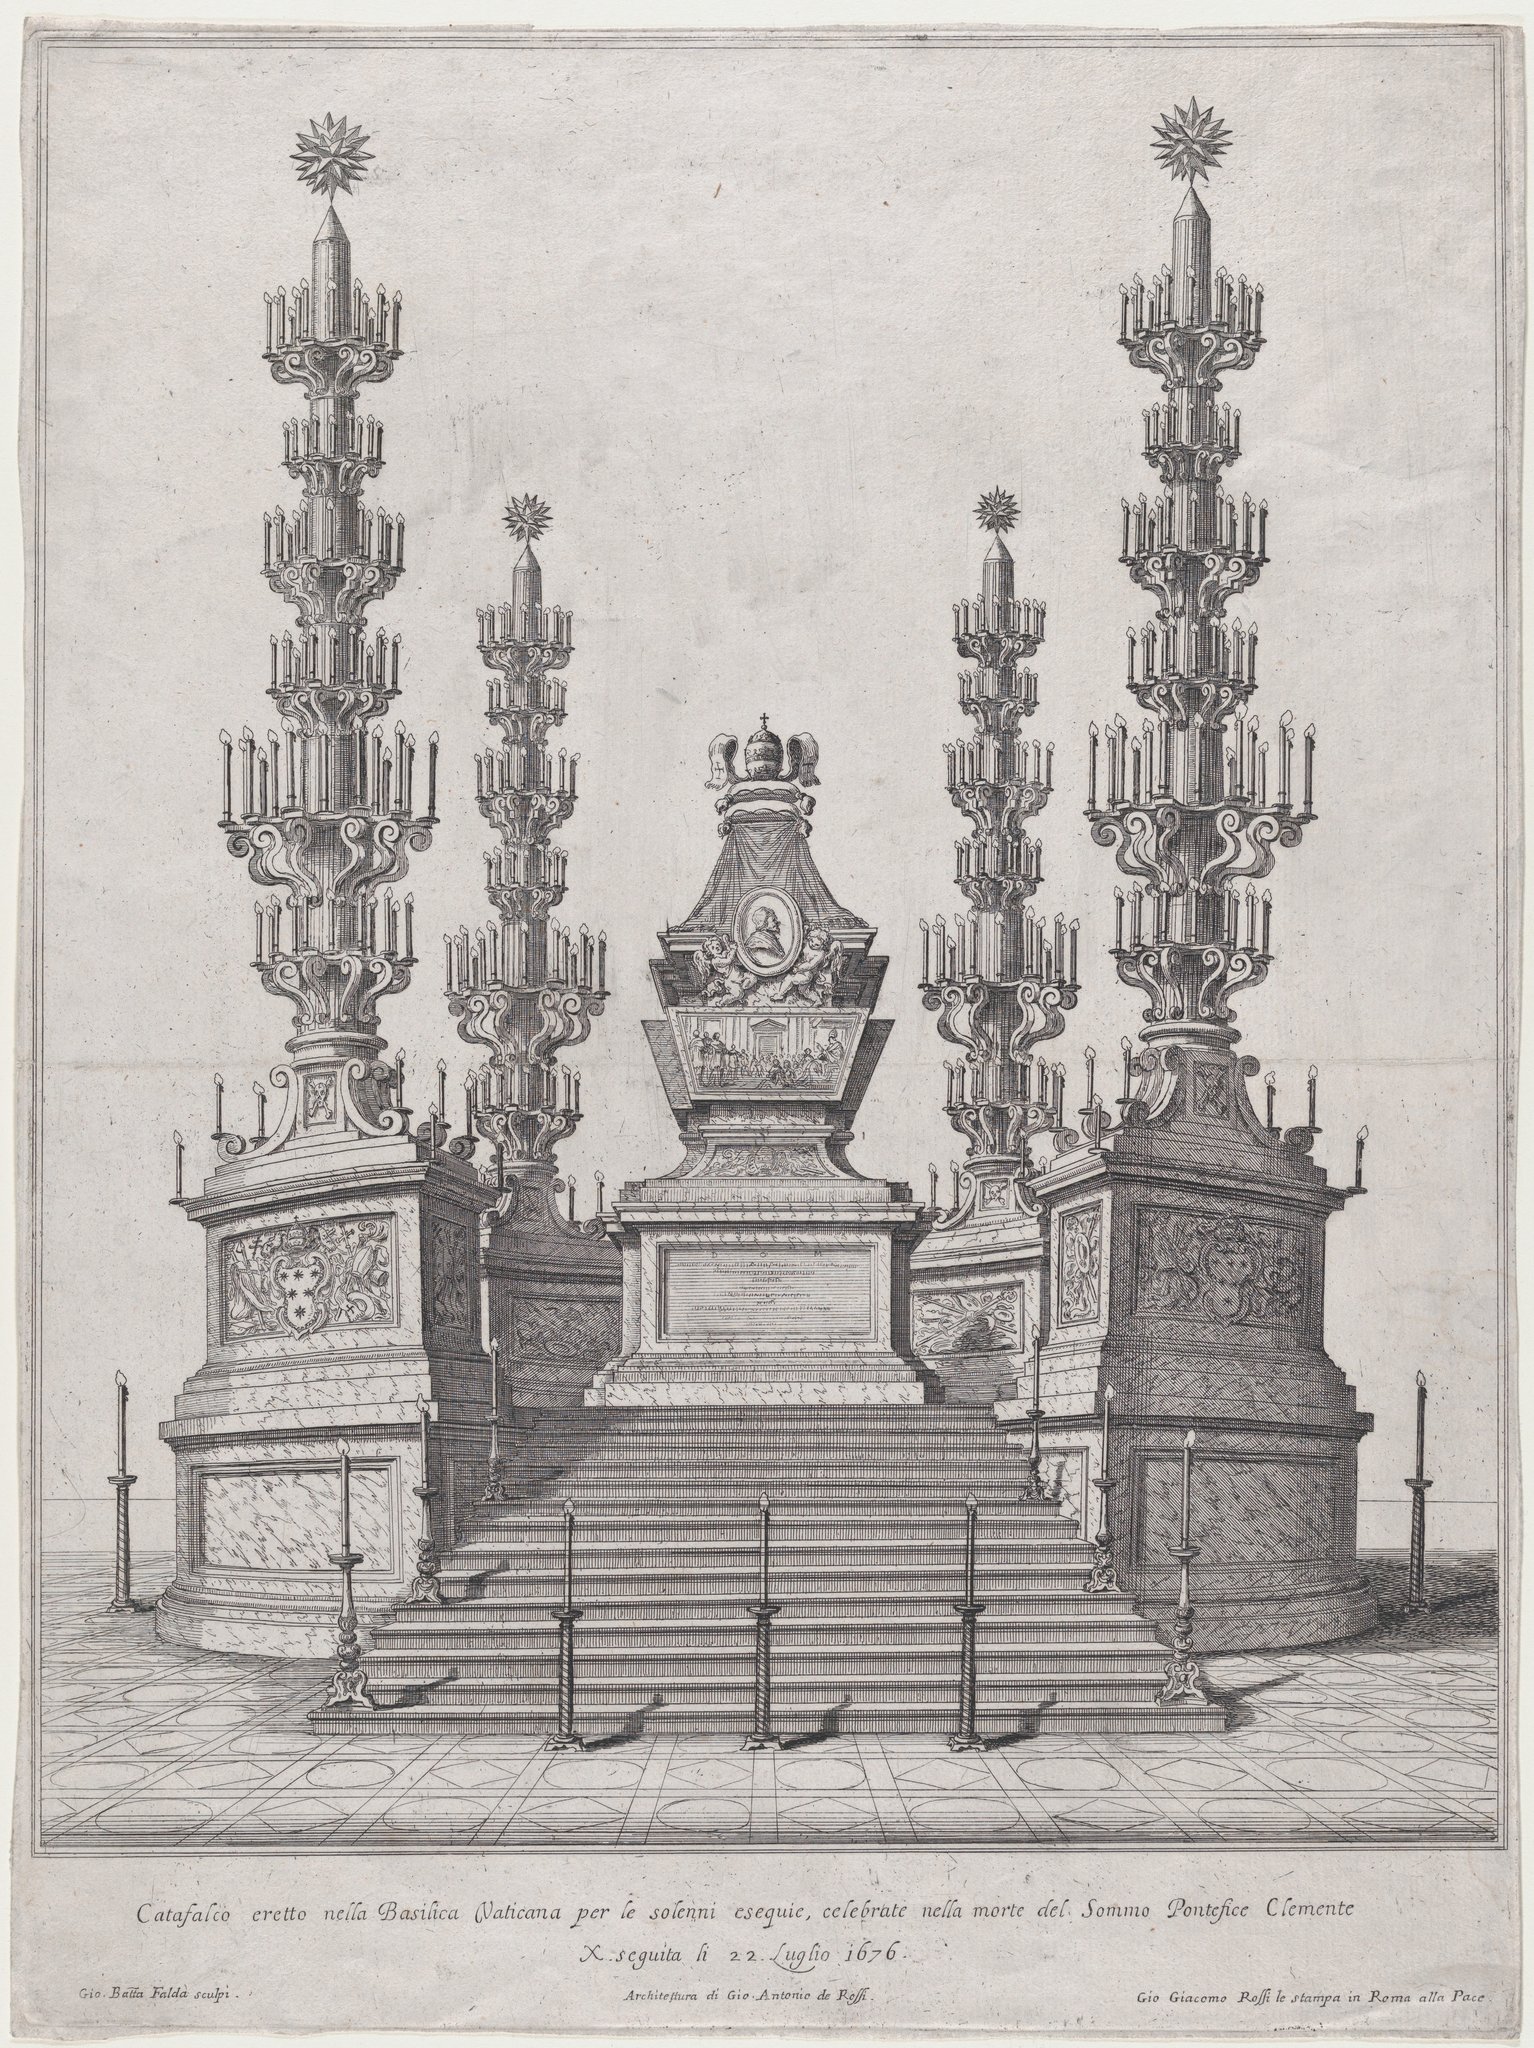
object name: print, fete, ornament architecture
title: Catafalque for Pope Clement X; central structure at the top of a fifteen step platform, with columns surmounted by candelabra at each of the four corners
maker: giovanni battista falda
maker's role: artist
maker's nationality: italian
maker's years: 1643-1678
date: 1676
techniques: etching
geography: rome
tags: monuments,candelabra